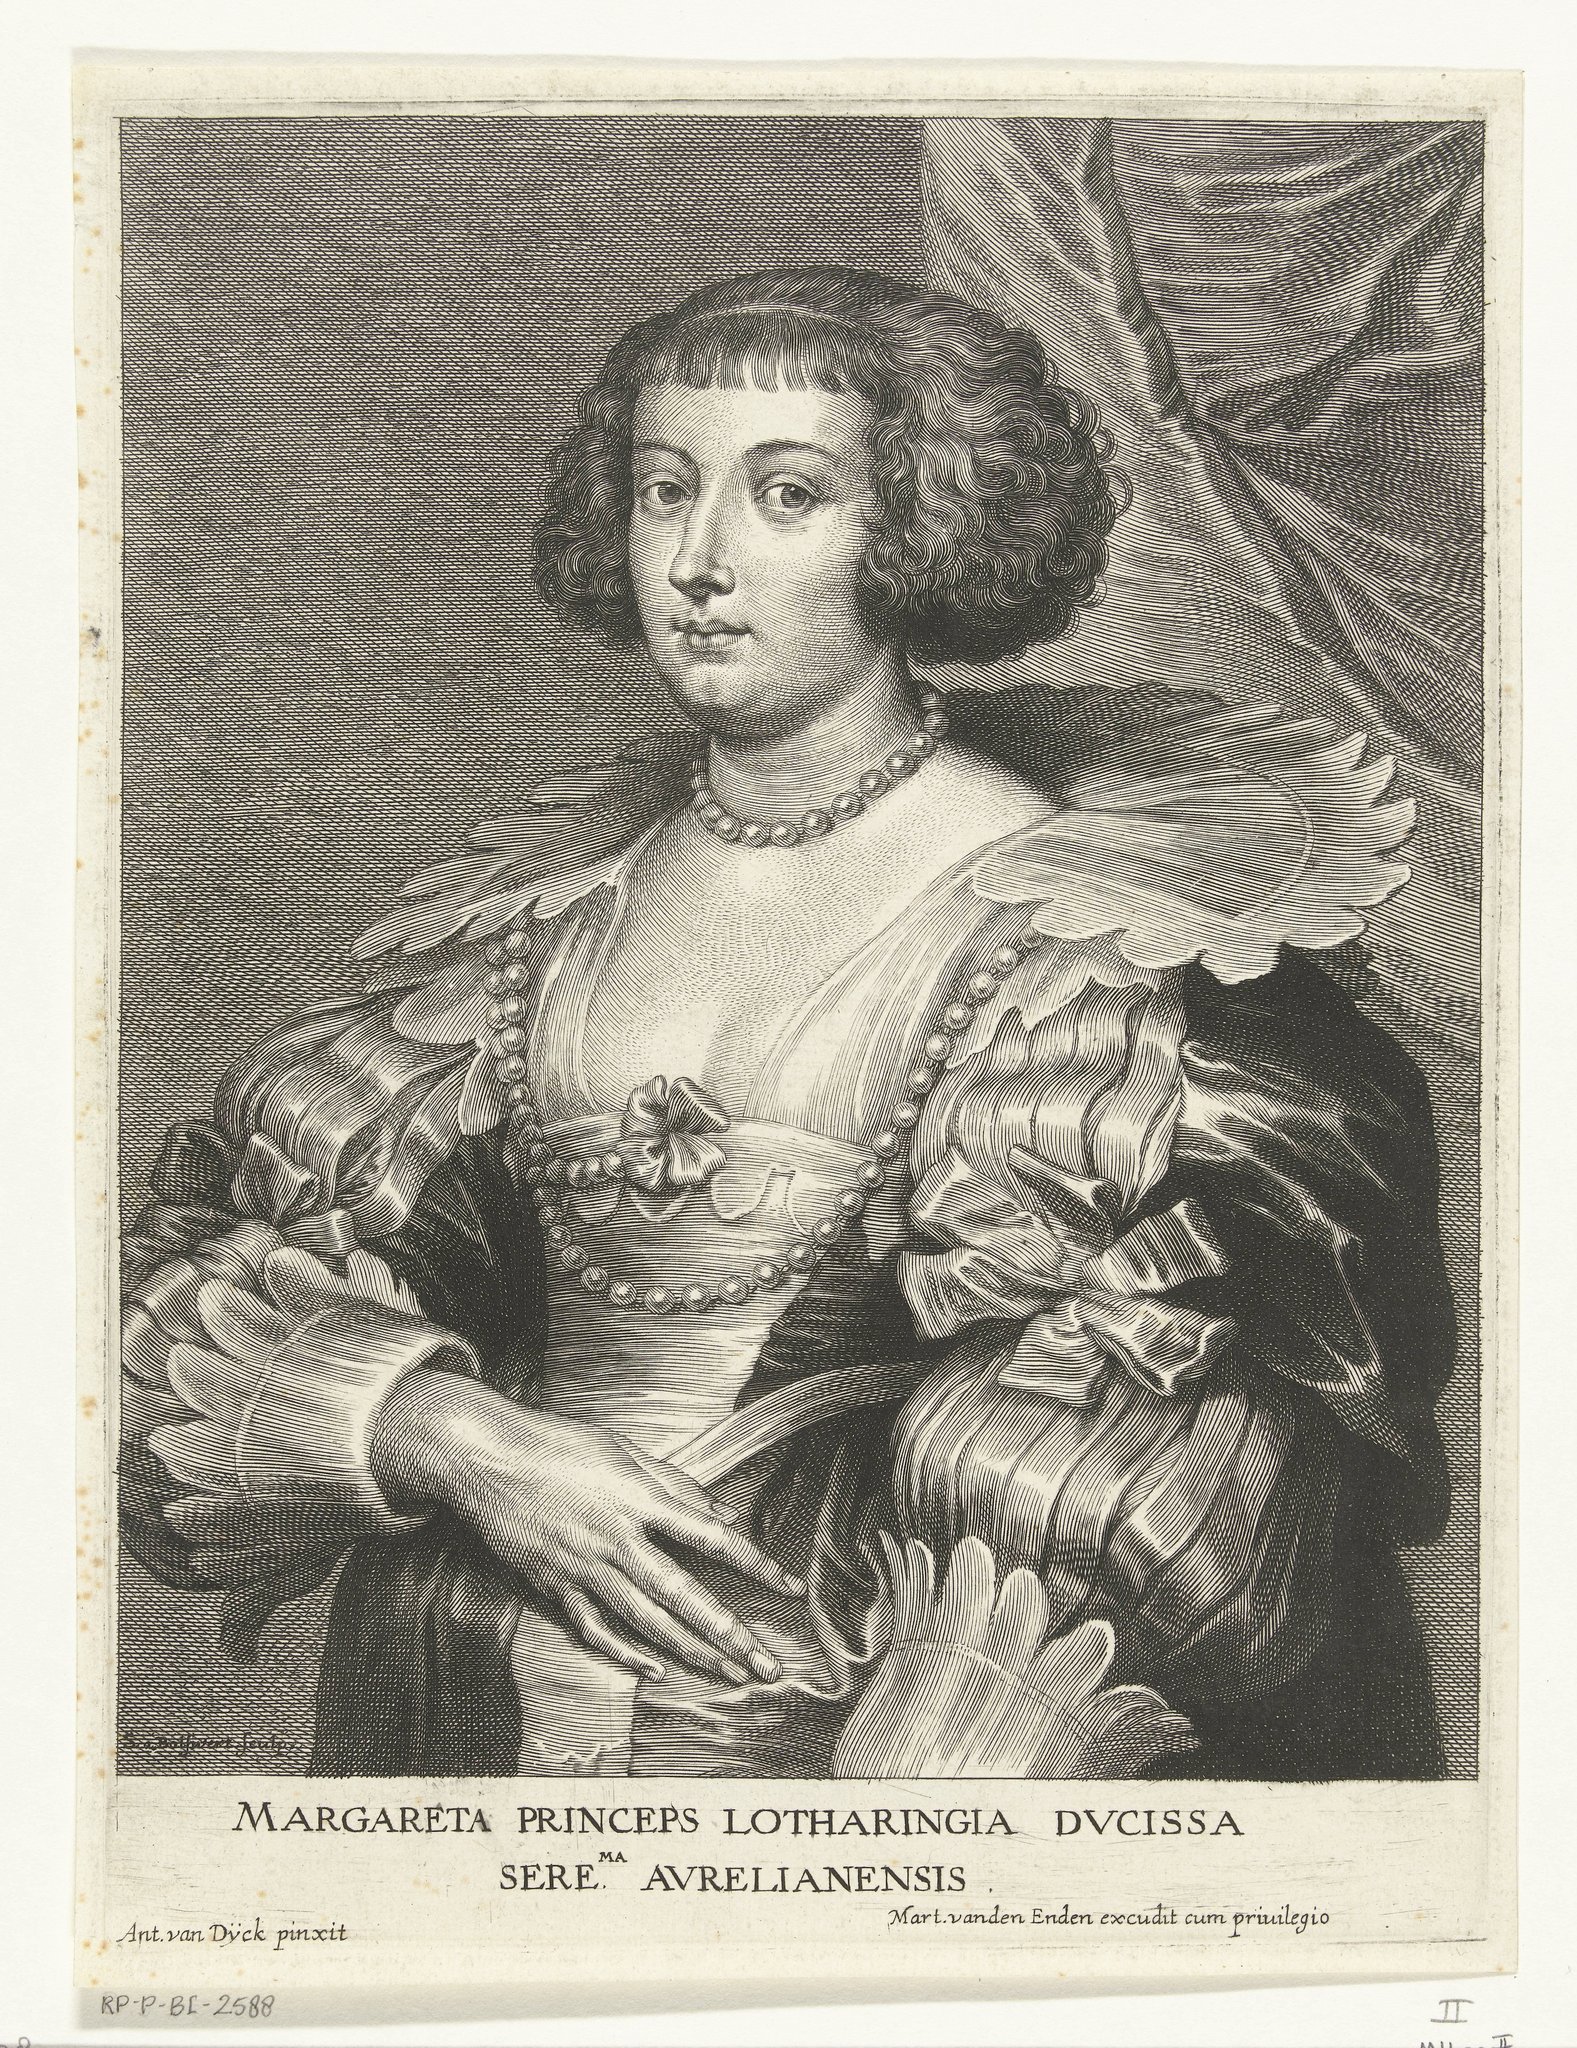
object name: print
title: Portret van Margaretha, prinses van Lotharingen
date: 1596-1659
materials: paper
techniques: engraving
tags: argentan, margaretha van lotharingen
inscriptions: collector's mark: Lugt 240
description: Prent naar schilderij van Anthony van Dyck dat zich bevindt in de collectie van de Galleria Degli Uffizi, Florence.